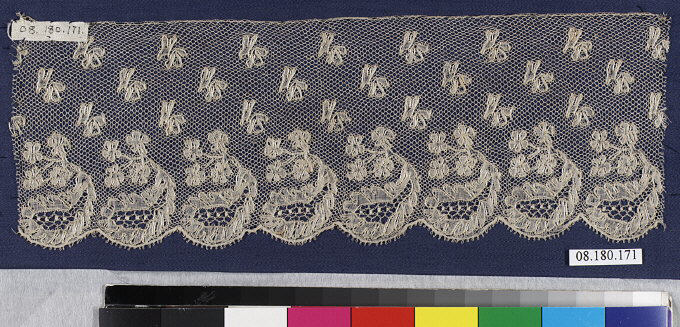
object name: fragment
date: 1801-1900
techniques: lace